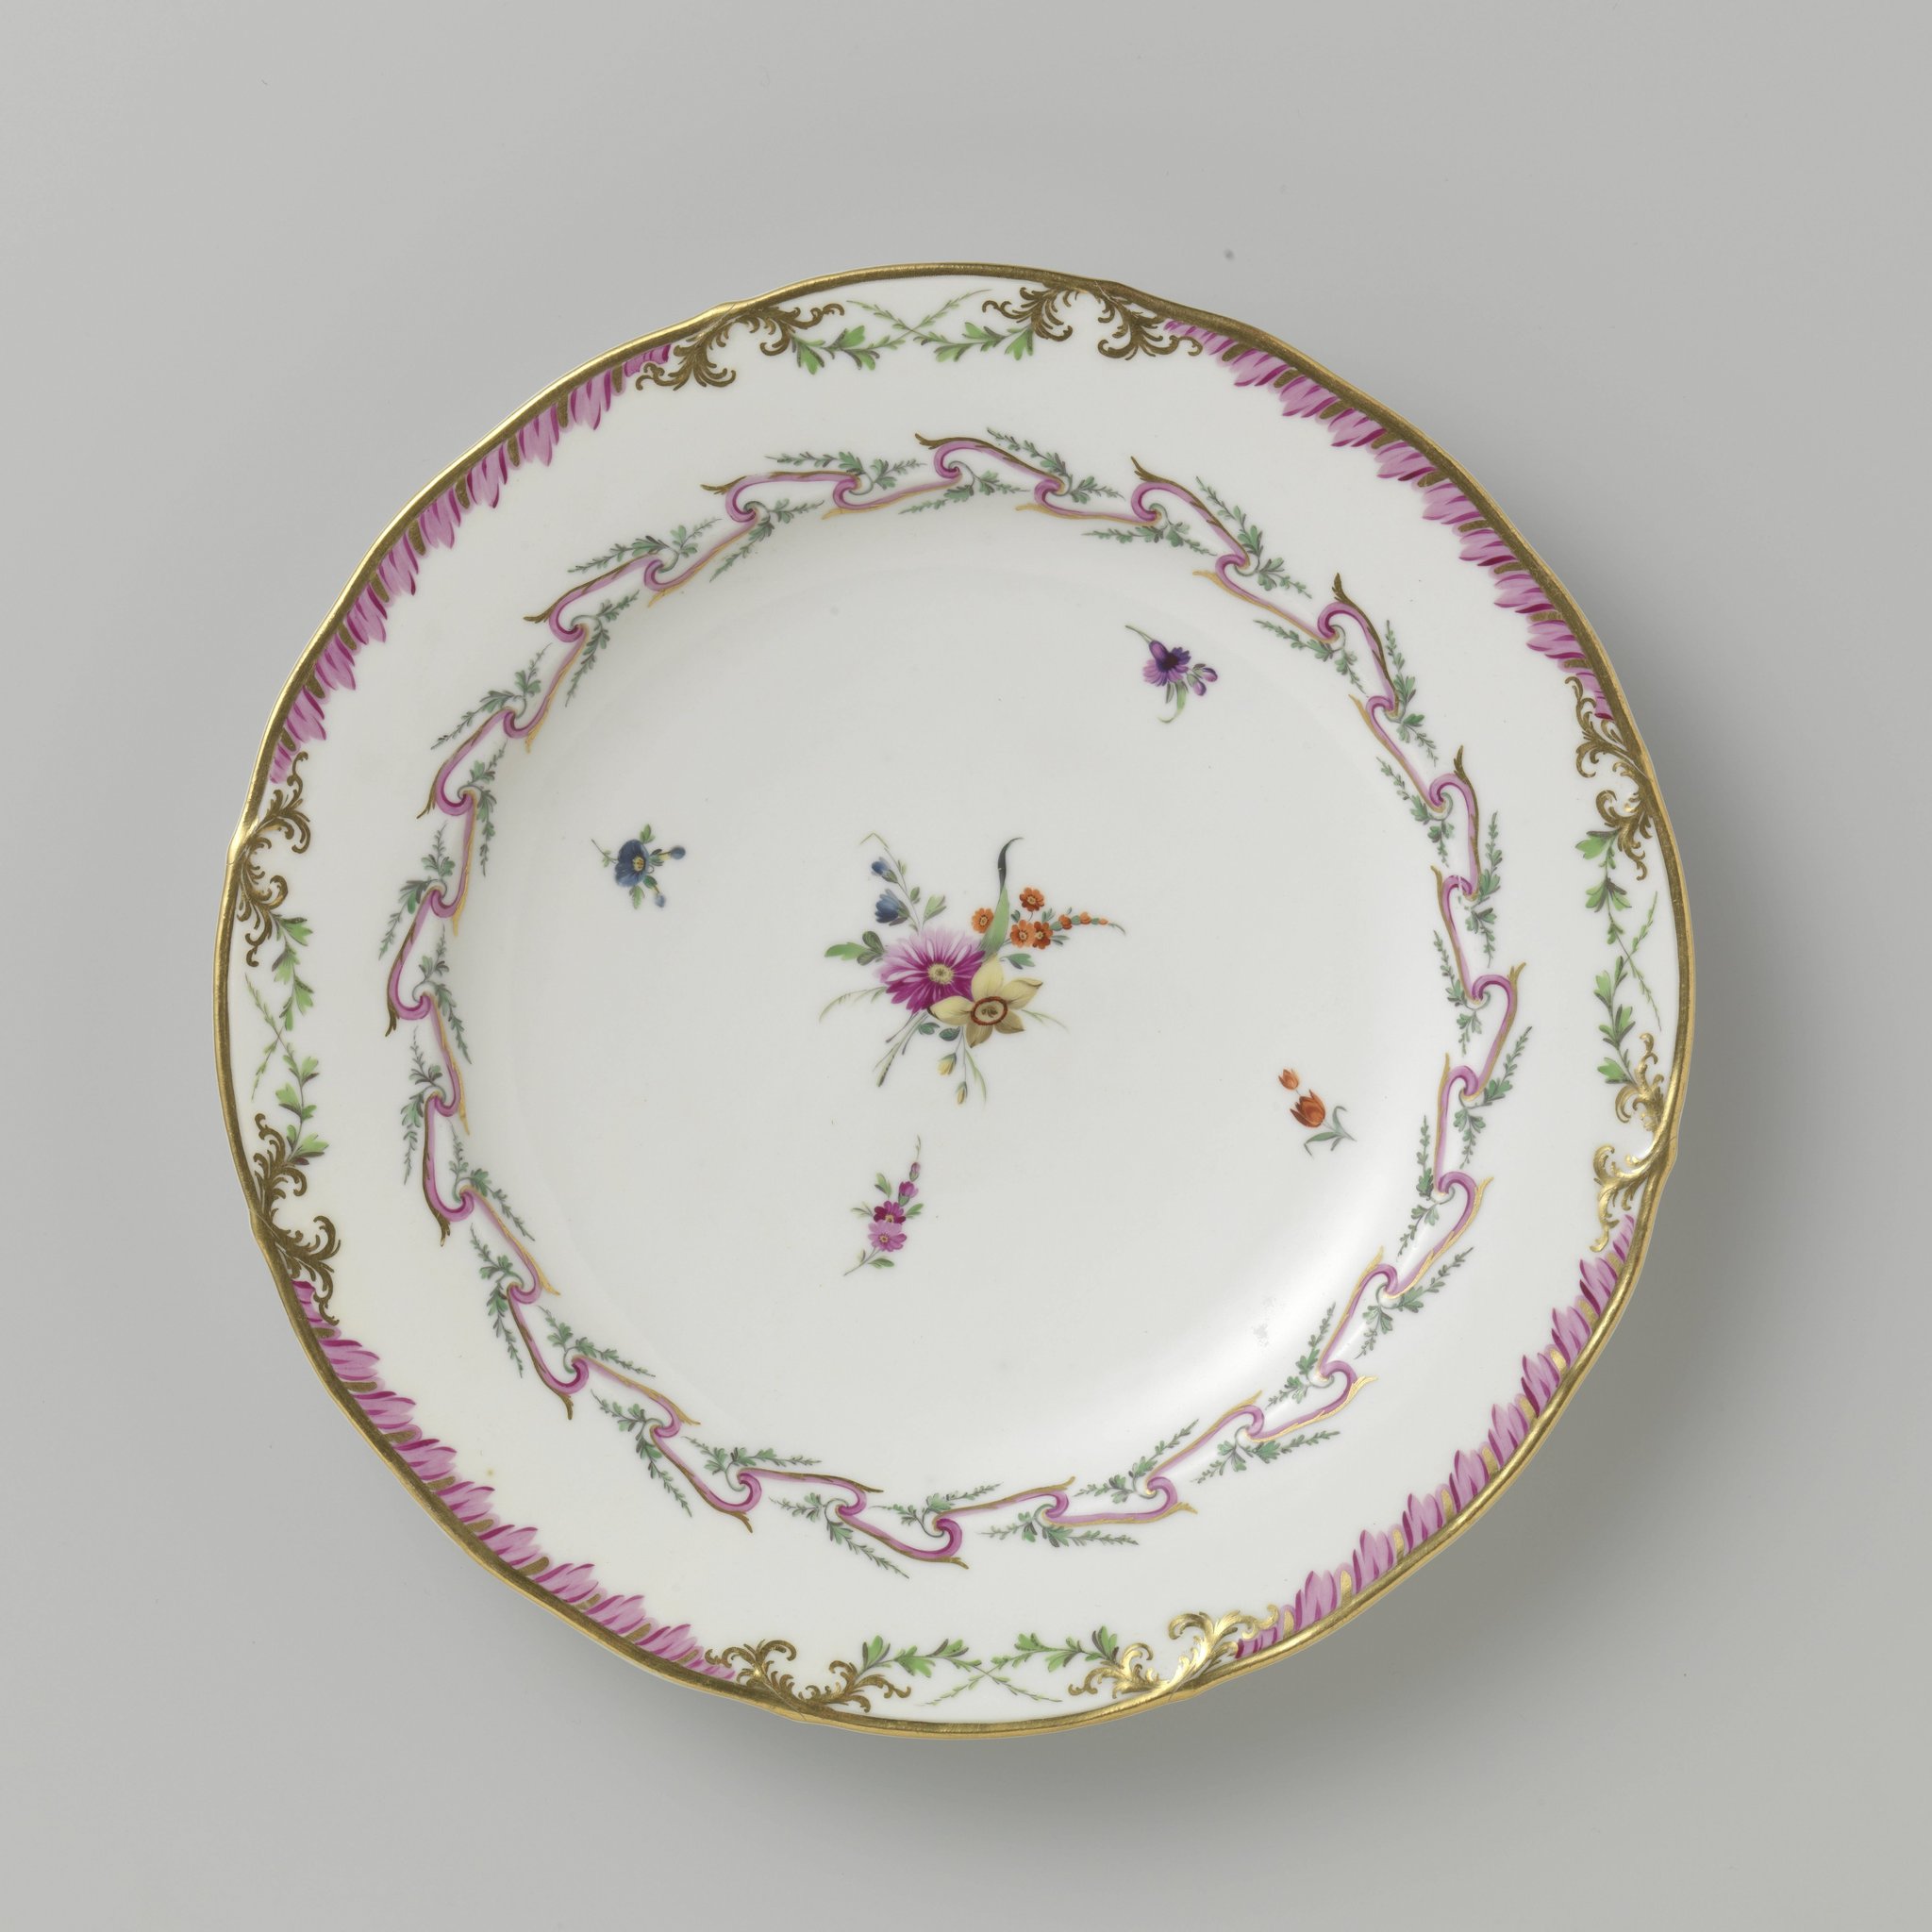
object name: plate dish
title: Bord, plat model, behorend bij een servies met geslingerd lintmotief met bladertakken, bloemboeketten en gestrooide bloemtakken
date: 1780-1820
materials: porcelain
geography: amsterdam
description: Bord, plat model, behorend bij een servies van porselein met geslingerd lintmotief in paars en goud met groene bladertakken, bloemboeketten en gestrooide bloemtakken. Randen lichtgegolfd met decoratie in goud met paars bladmotief waartussen groen gekruist bladmotief. Gemerkt: M.O.L. of AMSTEL.